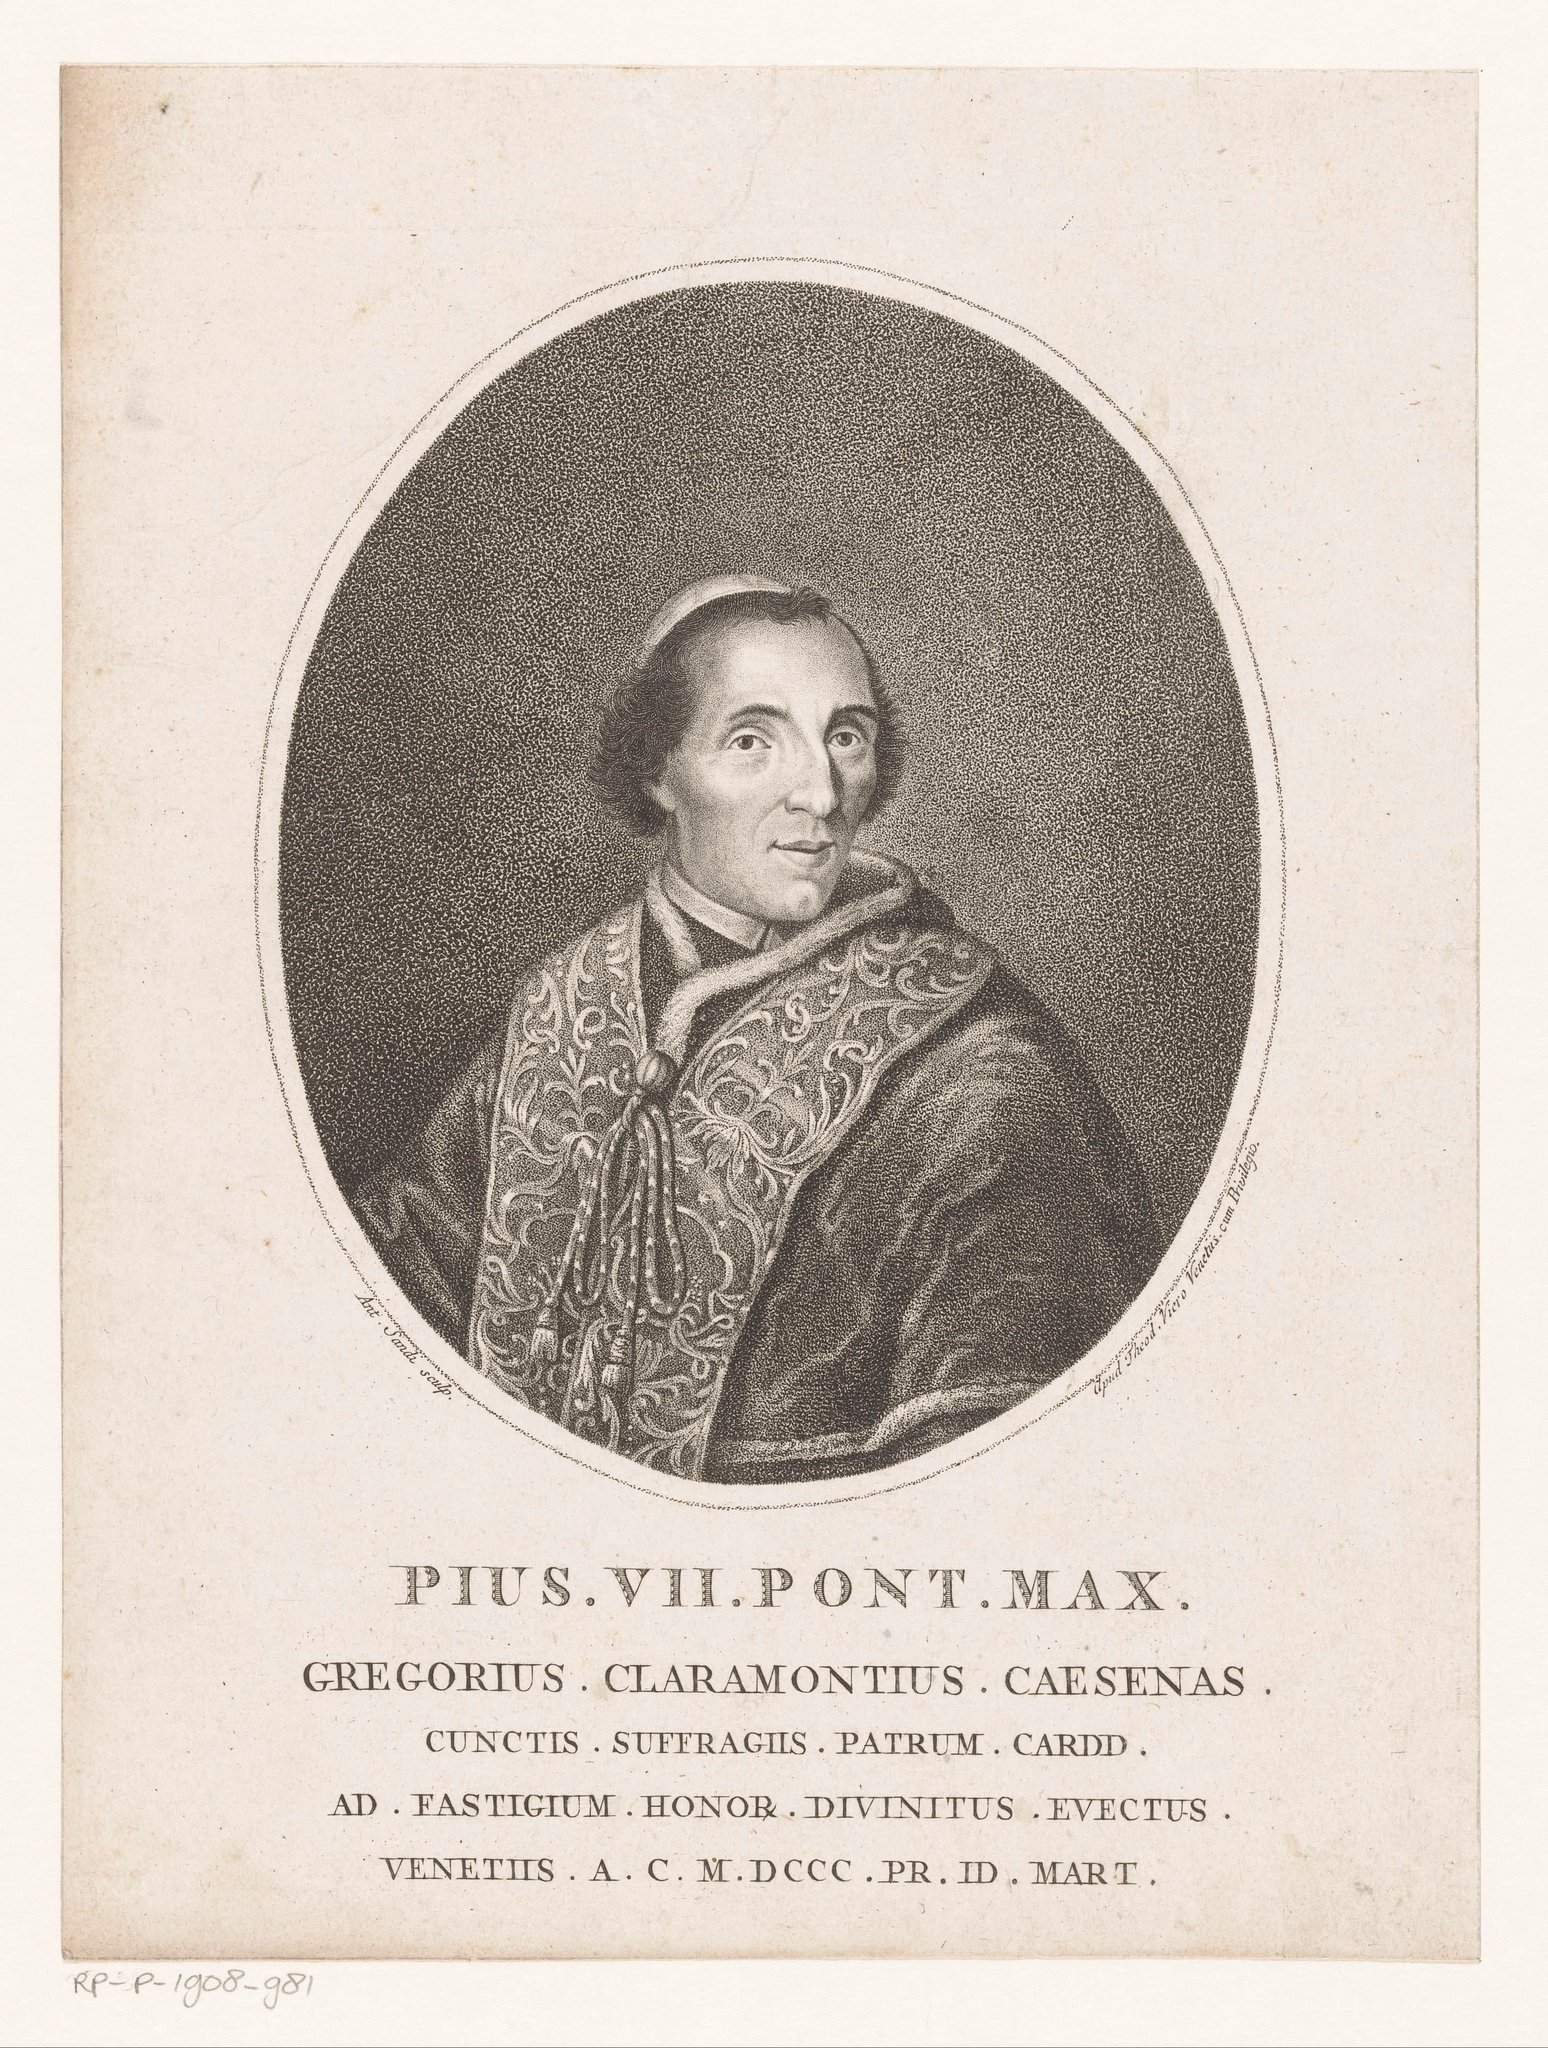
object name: print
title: Portret van paus Pius VII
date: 1800-1817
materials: paper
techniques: etching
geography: italy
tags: rome, pius vii, historical persons, pope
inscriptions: collector's mark: Lugt 2228